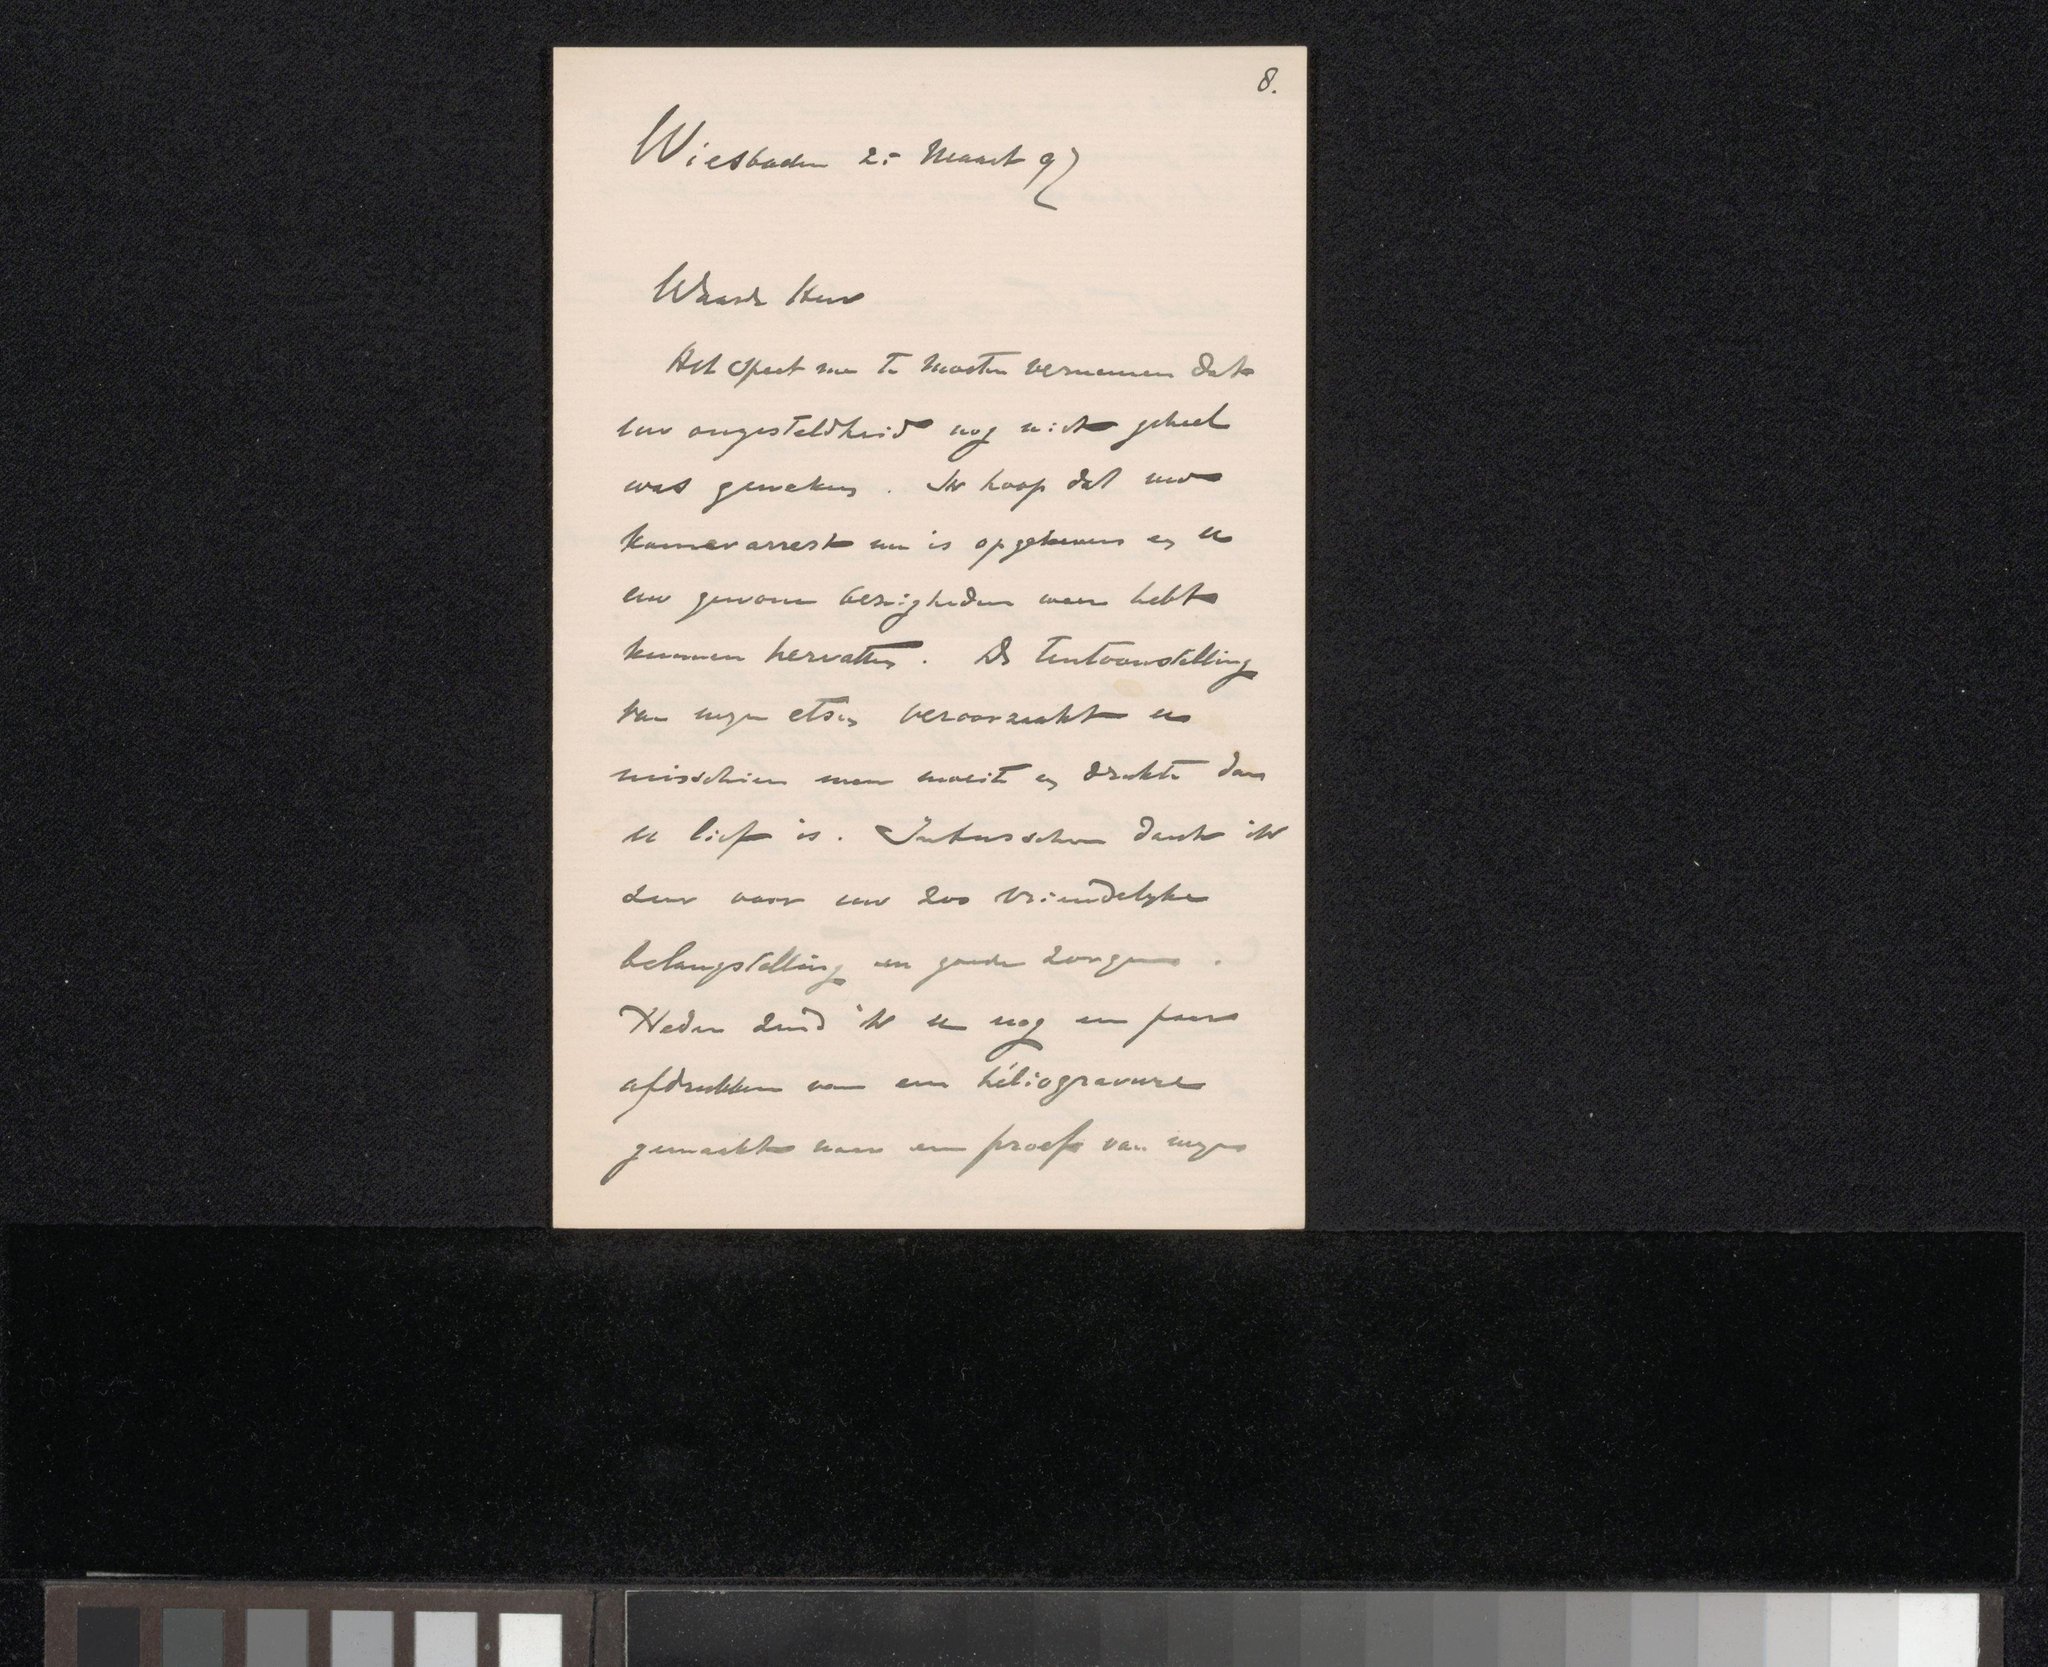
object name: letter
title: Brief aan Pieter Haverkorn van Rijsewijk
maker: carel nicolaas storm van s-gravesande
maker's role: draughtsman, print maker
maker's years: 1841-1924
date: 1897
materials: ink, paper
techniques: pen, writing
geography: wiesbaden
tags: pieter haverkorn van rijsewijk, the graphic arts, exhibition ~ art, diseases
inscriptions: collector's mark: ‘RPK’